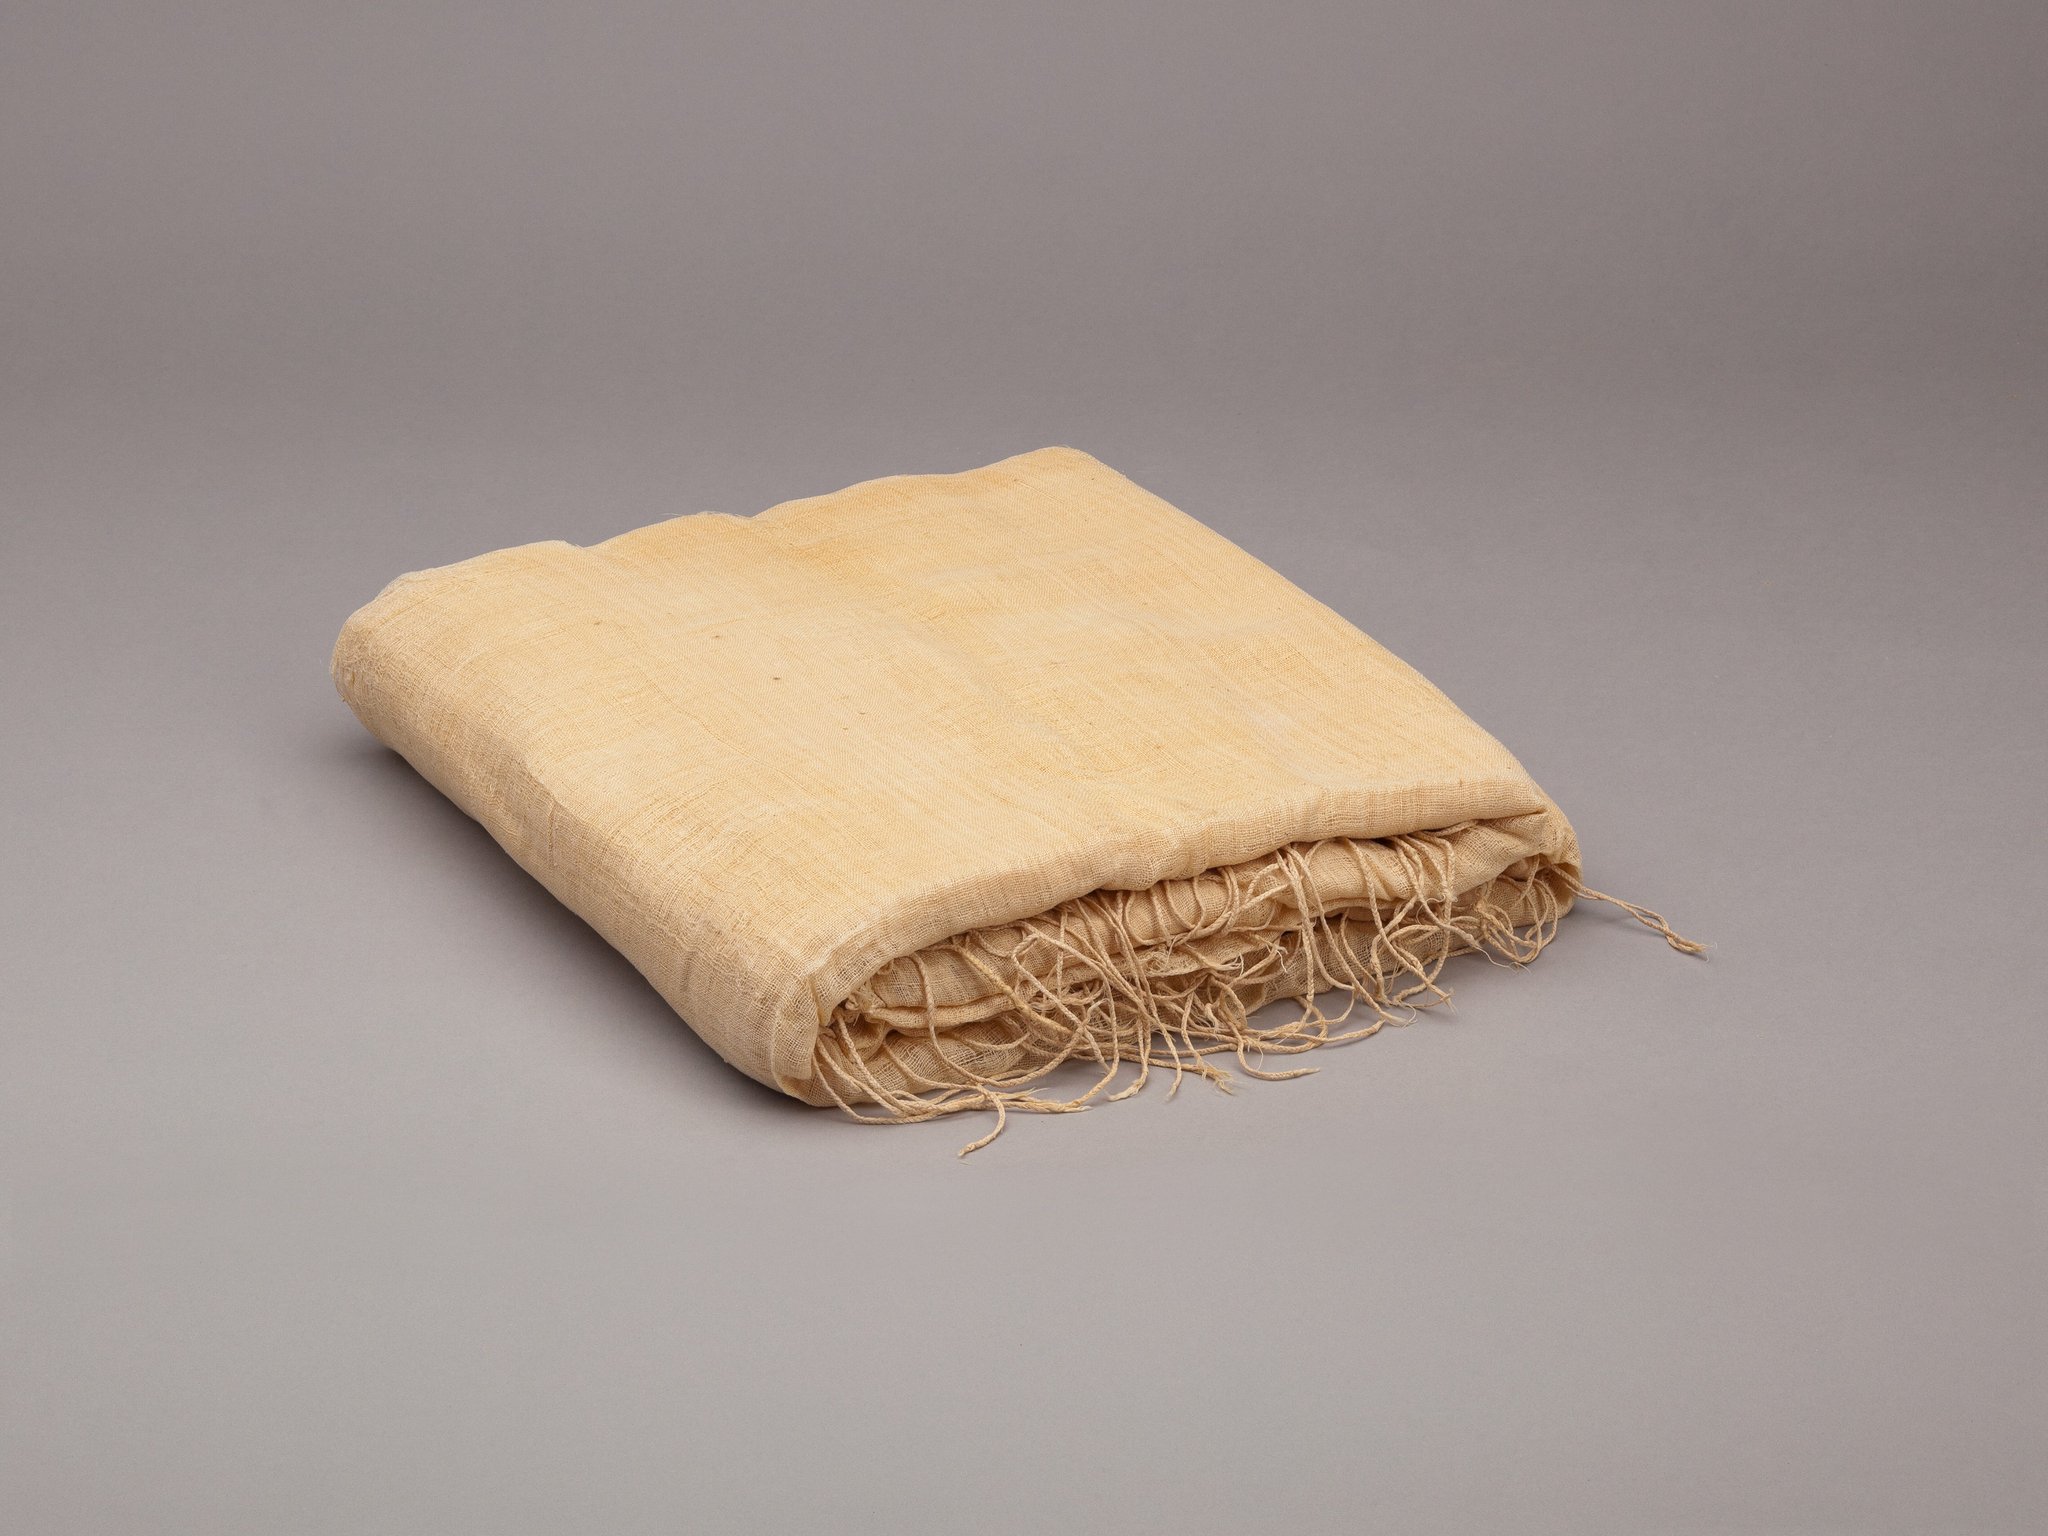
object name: linen mark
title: Sheet, linen mark, medium spin, loose weave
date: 1492-1473 BCE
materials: linen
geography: egypt